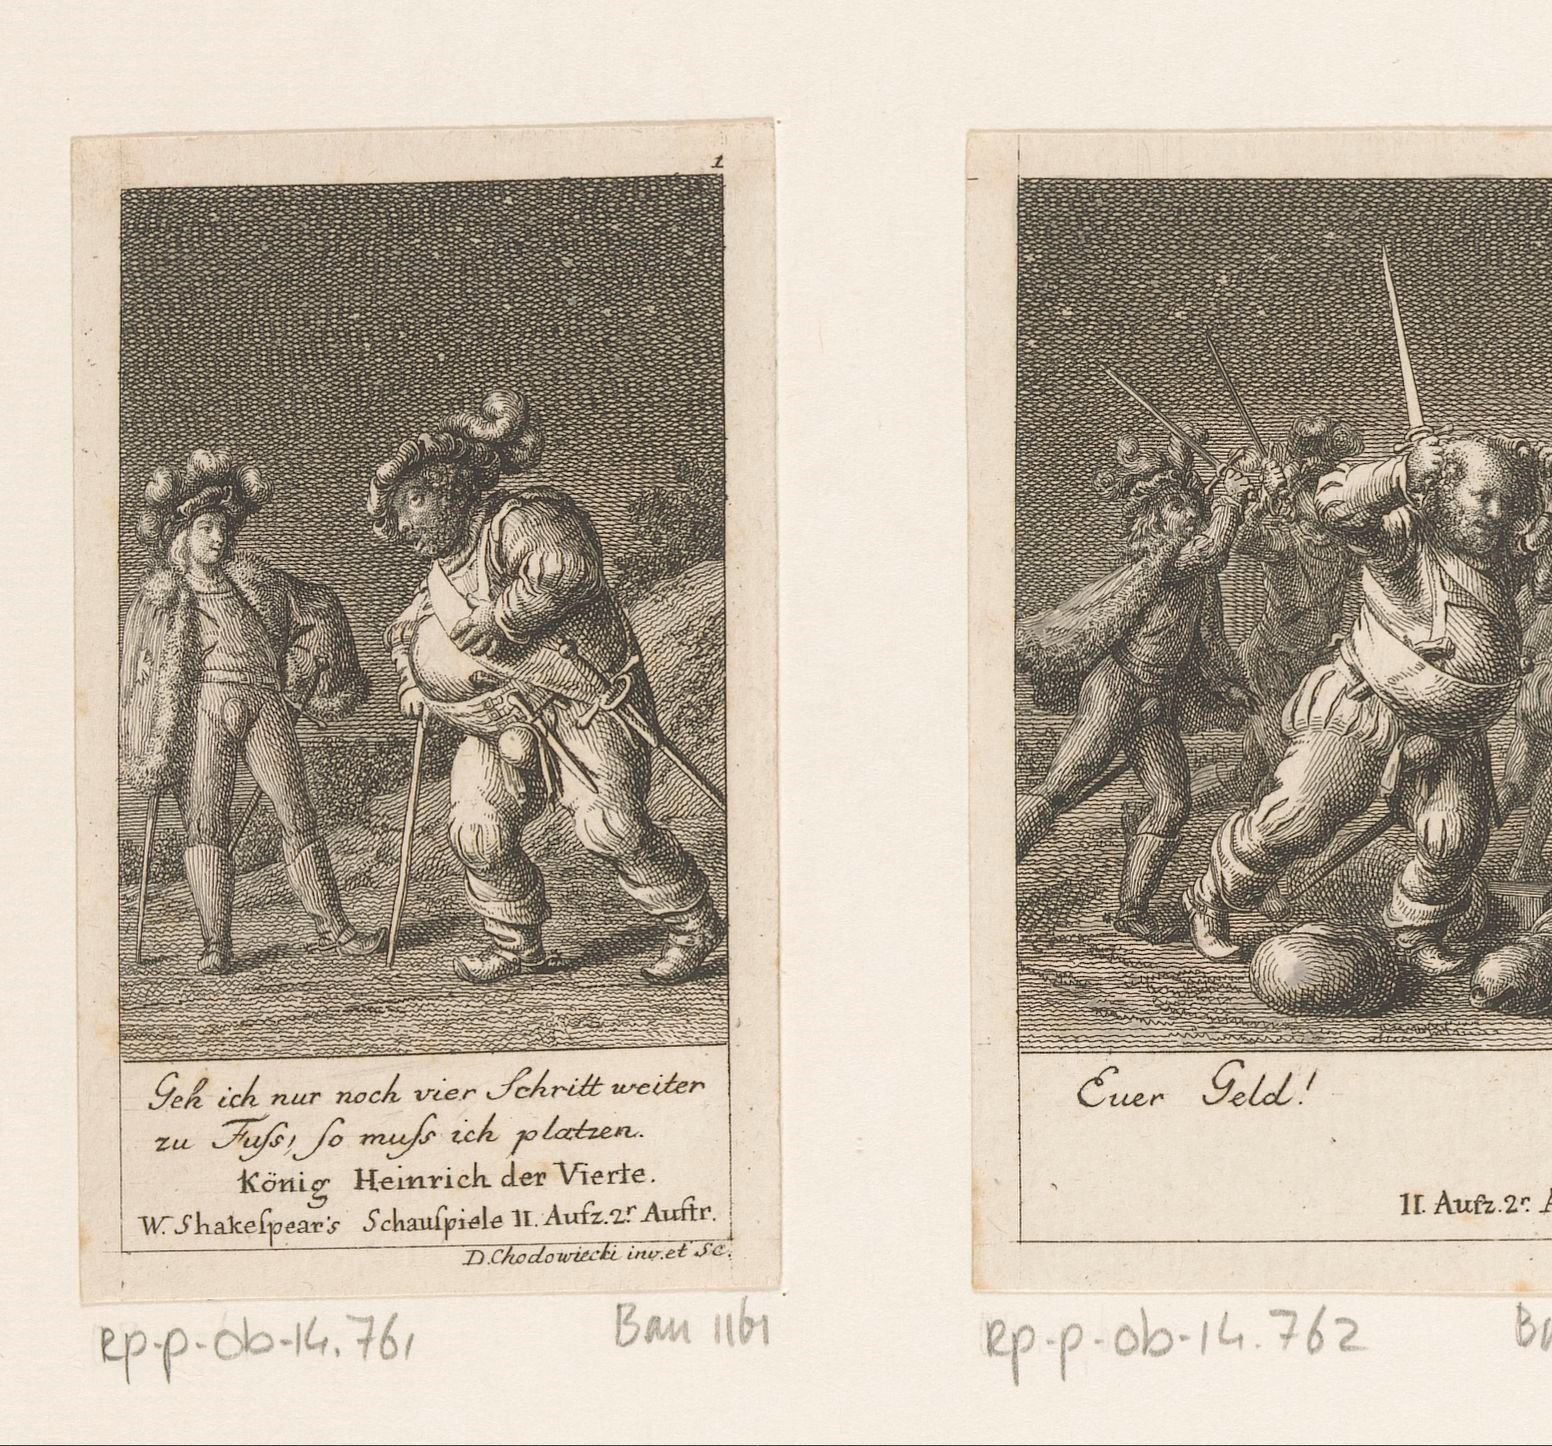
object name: print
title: Prins Henry en Falstaff in de buurt van Gadshill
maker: daniel nikolaus chodowiecki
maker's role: draughtsman, print maker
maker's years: 1726-1801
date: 1785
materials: paper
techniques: etching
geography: berlin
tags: william shakespeare, fat (human type), literature, prince, falstaff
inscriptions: collector's mark: Lugt 2228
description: Vervaardigd voor William Shakespeares 'Henry IV'. Prent gebruikt voor: Goettinger Taschen Calender vom Jahr 1786. Göttingen: Johann Christoph Dietrich, 1785.